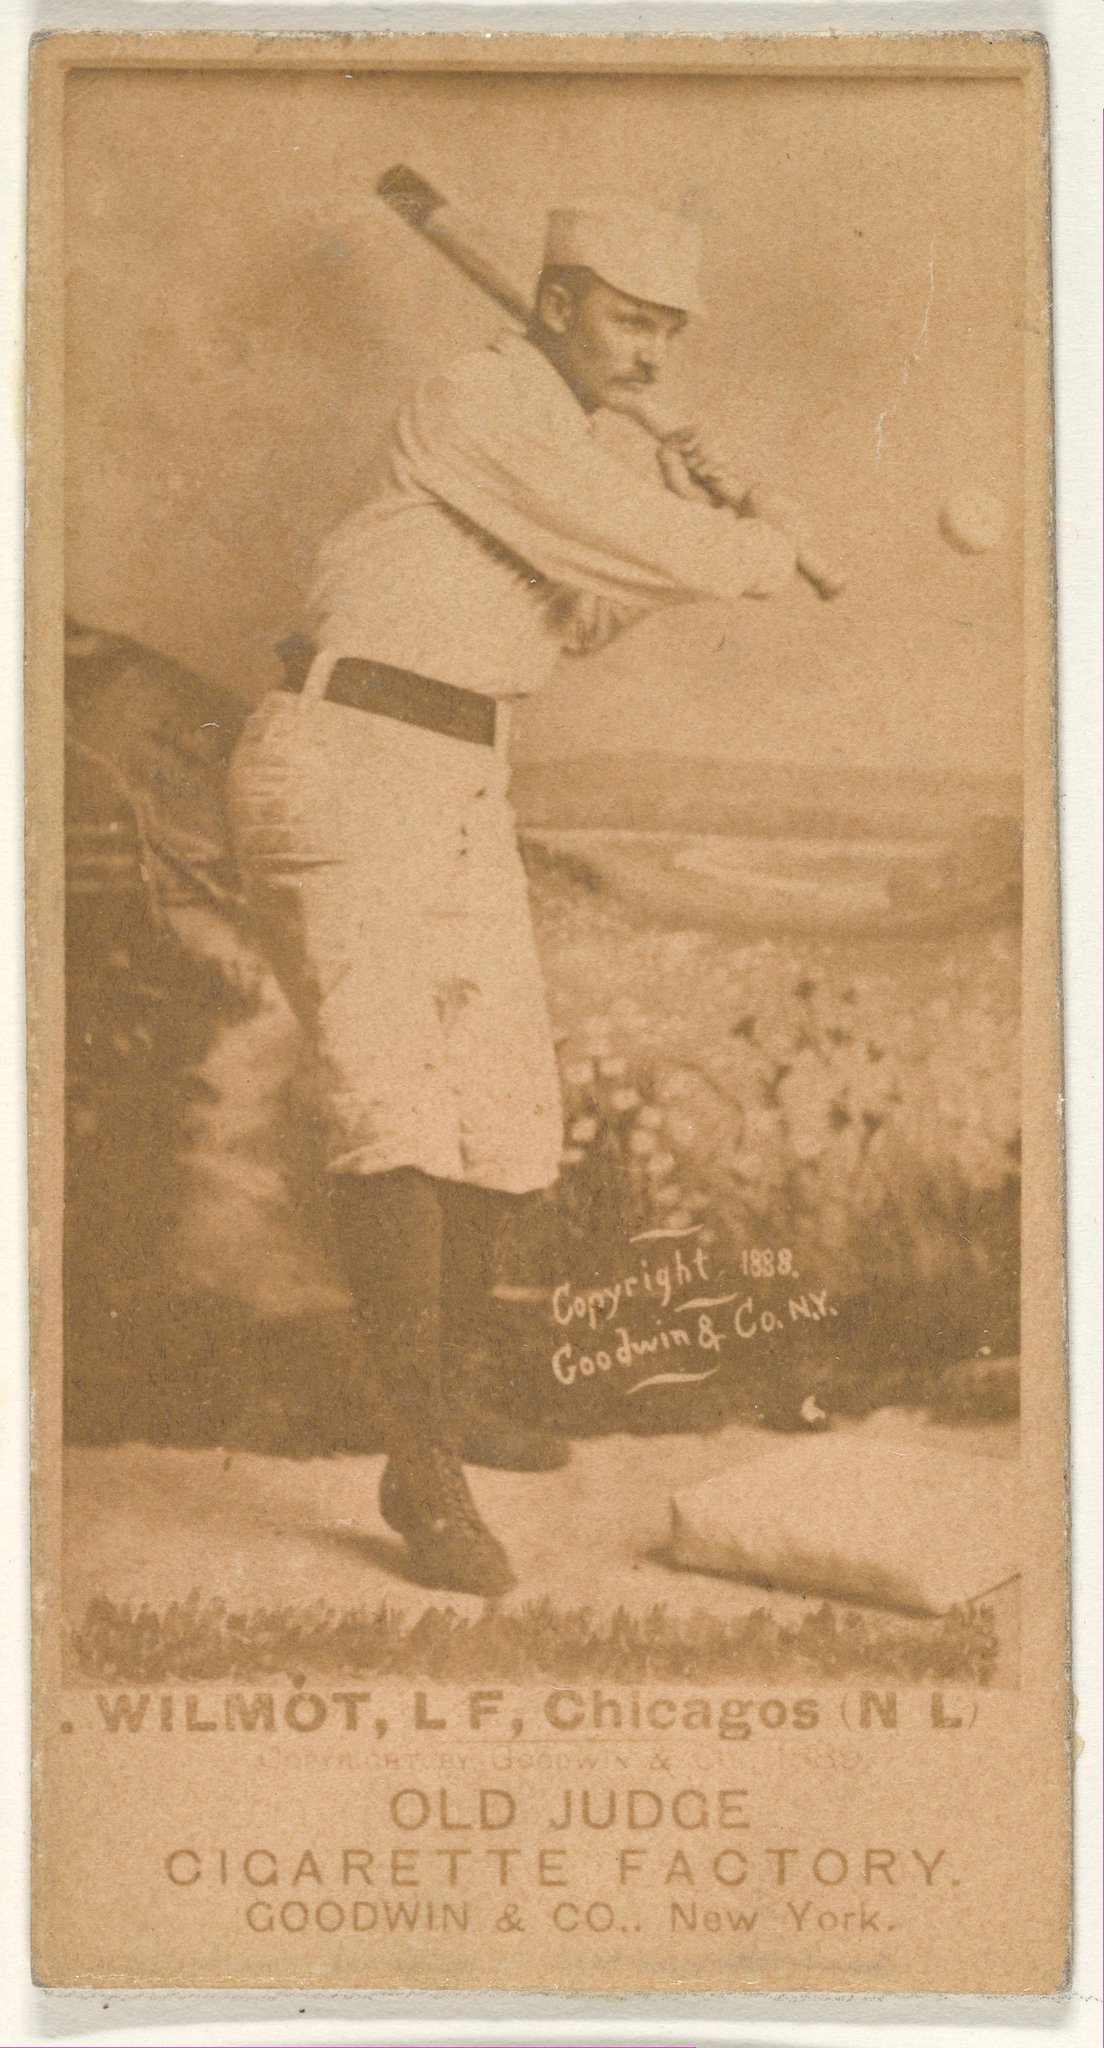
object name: baseball card, photograph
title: Wilmot, Left Field, Chicago, from the Old Judge series (N172) for Old Judge Cigarettes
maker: goodwin & company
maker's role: publisher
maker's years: 1850-1950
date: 1888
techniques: albumen silver print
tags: men,portraits,baseball,athletes